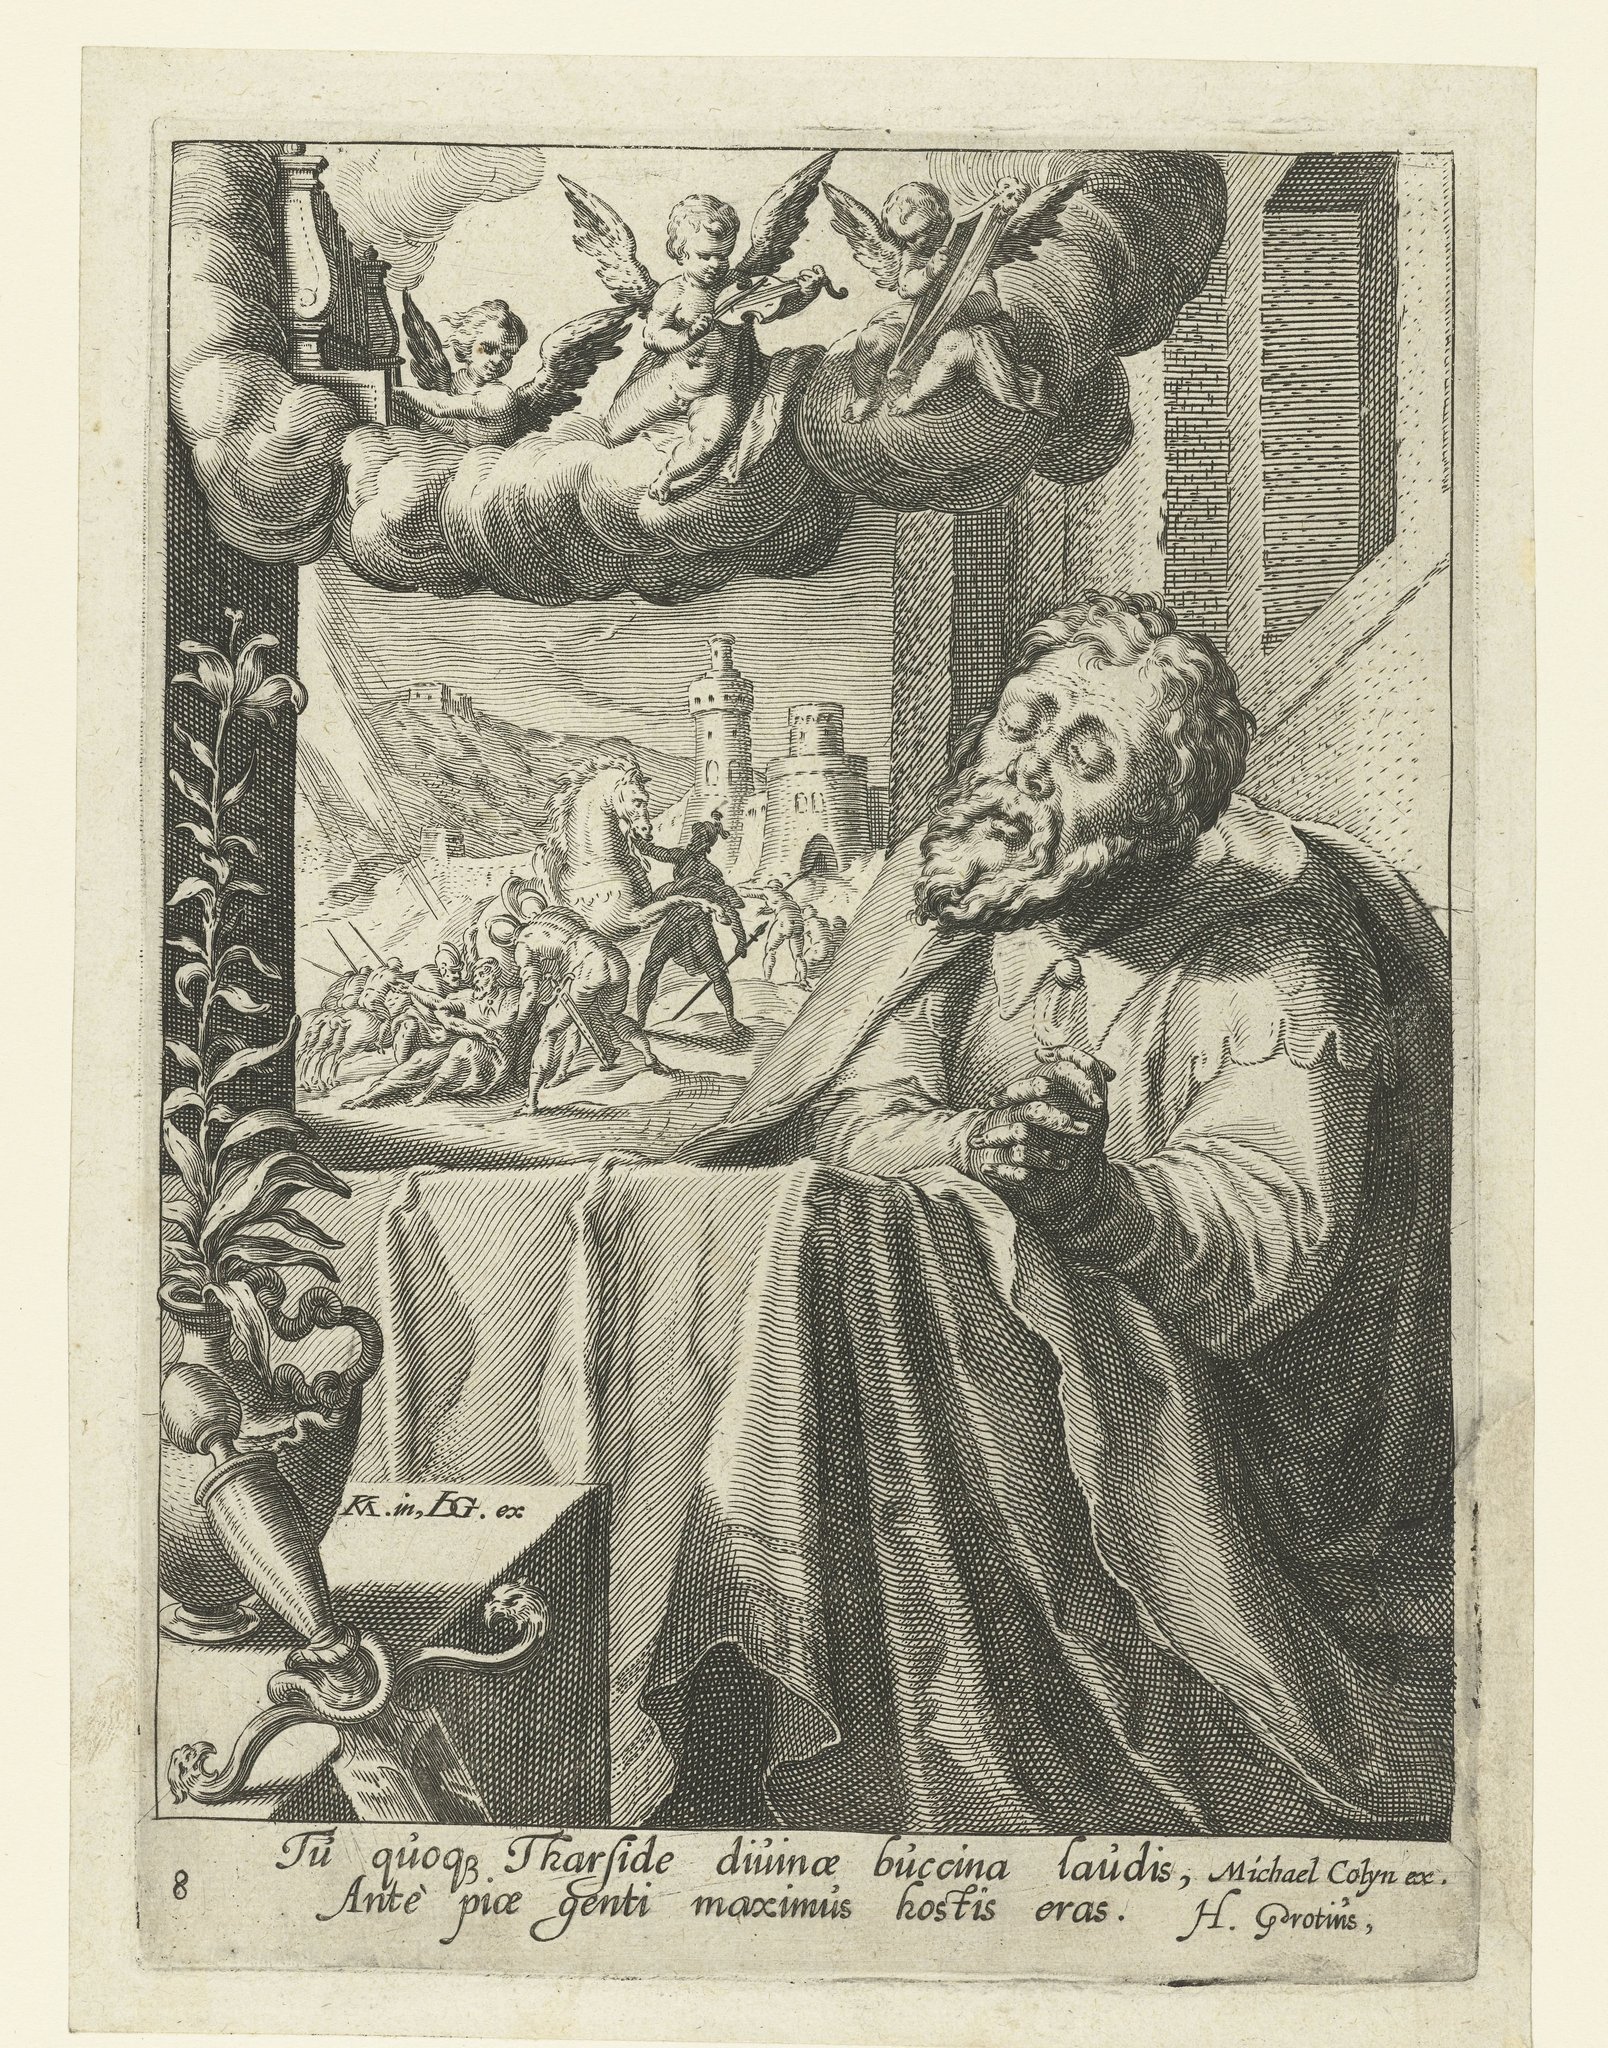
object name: print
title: Acht berouwvolle zondaars uit het Oude en Nieuwe Testament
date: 1595-1596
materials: paper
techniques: engraving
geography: amsterdam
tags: male persons from the old testament (with name) (not in biblical context) - personal devotions of male persons from the old testament, e.g. vision, prayer, penitence, story of the conversion of paul (acts 9:1-18)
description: Paulus, biddend aan een tafel, voor hem een lelie in een vaas en een zwaard. Op de achtergrond is een scène uit zijn leven verbeeld: het moment van zijn bekering na een val van zijn paard. Onder de voorstelling een tweeregelige Latijnse tekst. Deze prent is onderdeel van een serie van acht berouwvolle zondaars; elke prent in deze serie bestaat uit een beeltenis van een zondaar, boven hem/haar een aantal (musicerende) engeltjes in een wolkenkrans, op de achtergrond een scène uit het leven van de betreffende zondaar, onder de voorstelling twee regels tekst in Latijn.